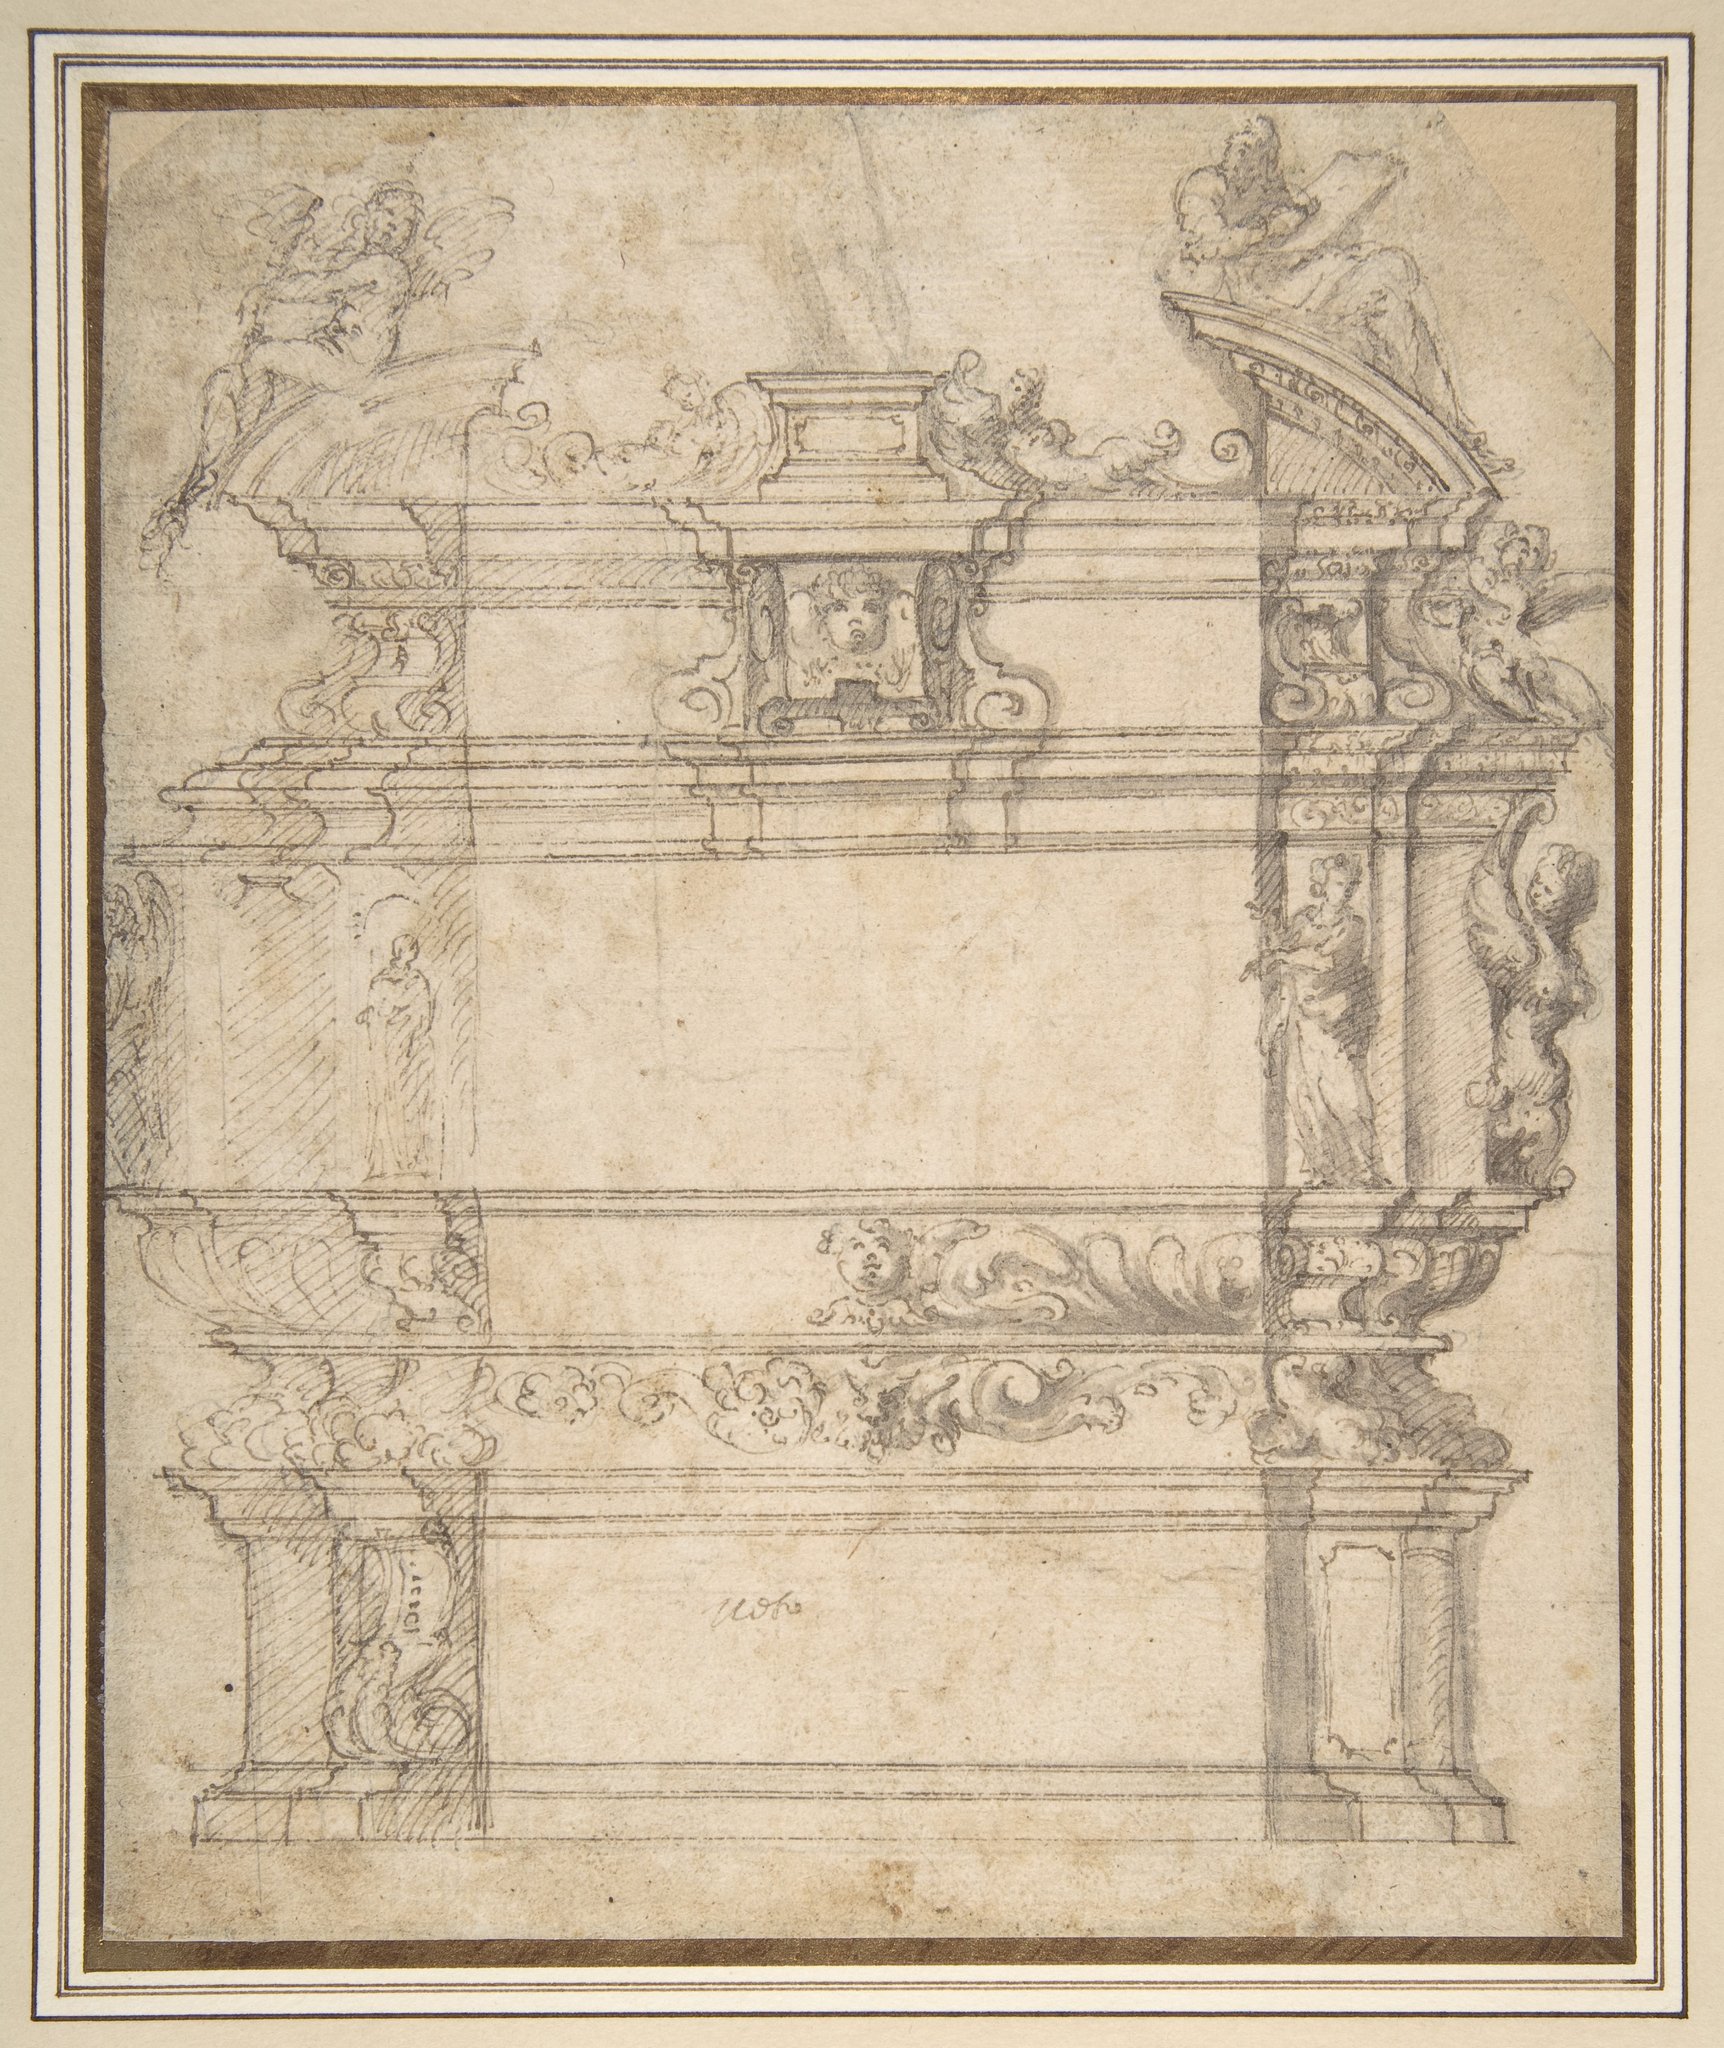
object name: drawing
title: Design for a Tomb with Female Figures, Putti and Mythological Creatures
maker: anonymous, italian, 16th century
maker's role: artist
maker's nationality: italian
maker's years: 1550-1600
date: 1501-1600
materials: ink, drawing material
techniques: brush, pen, wash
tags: tombs,women,cupid,putti